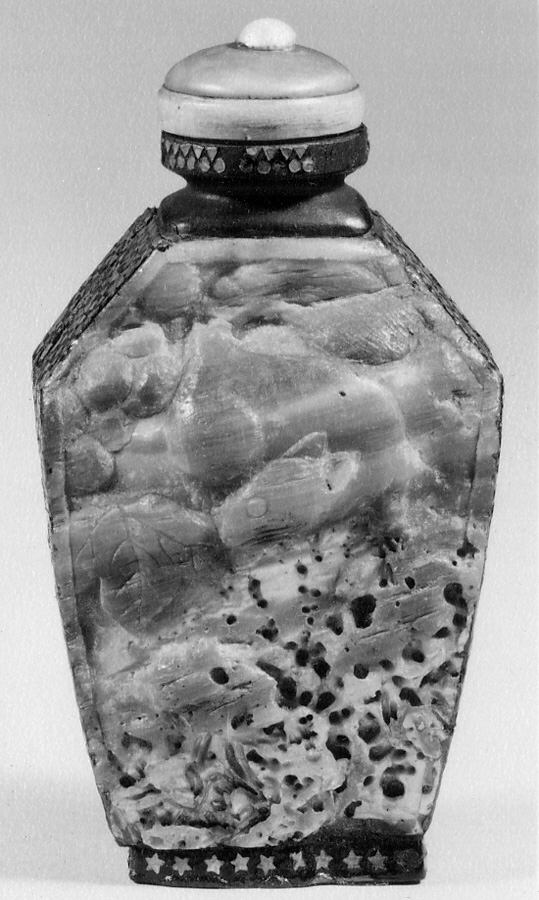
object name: snuff bottle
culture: chinese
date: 1801-1900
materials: coral, pearl